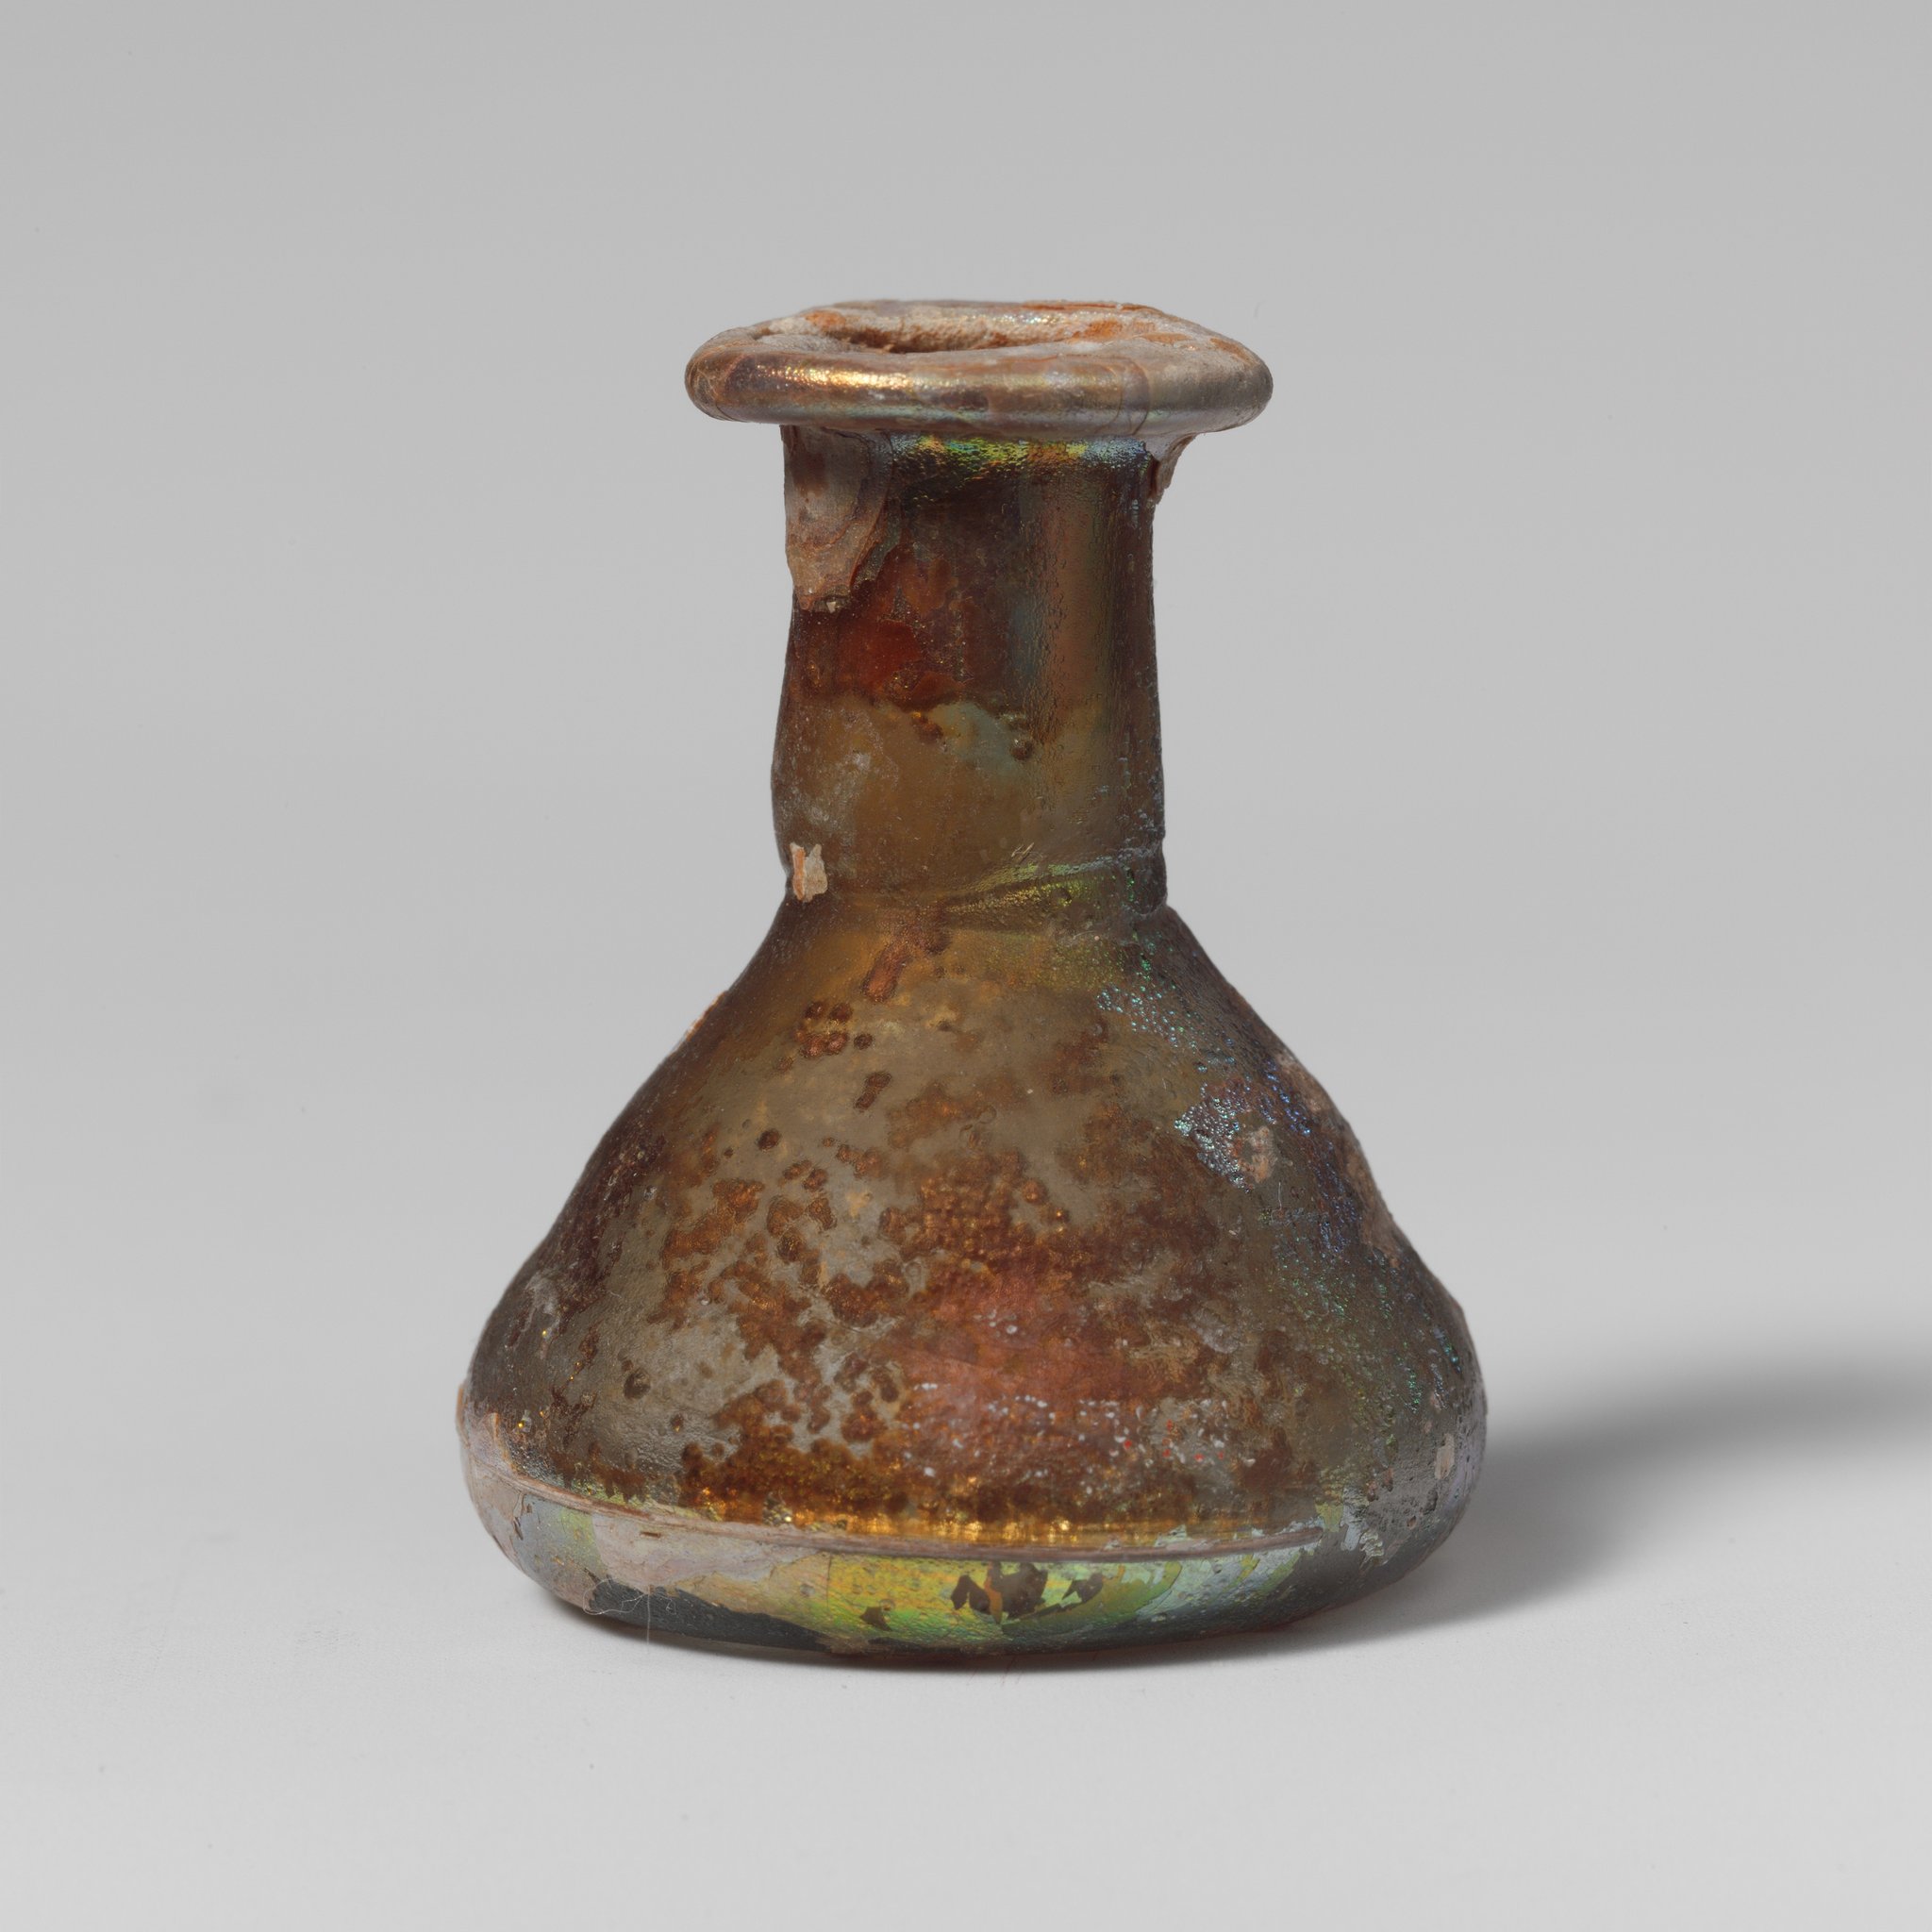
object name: perfume bottle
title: Glass perfume bottle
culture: roman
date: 1-200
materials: glass